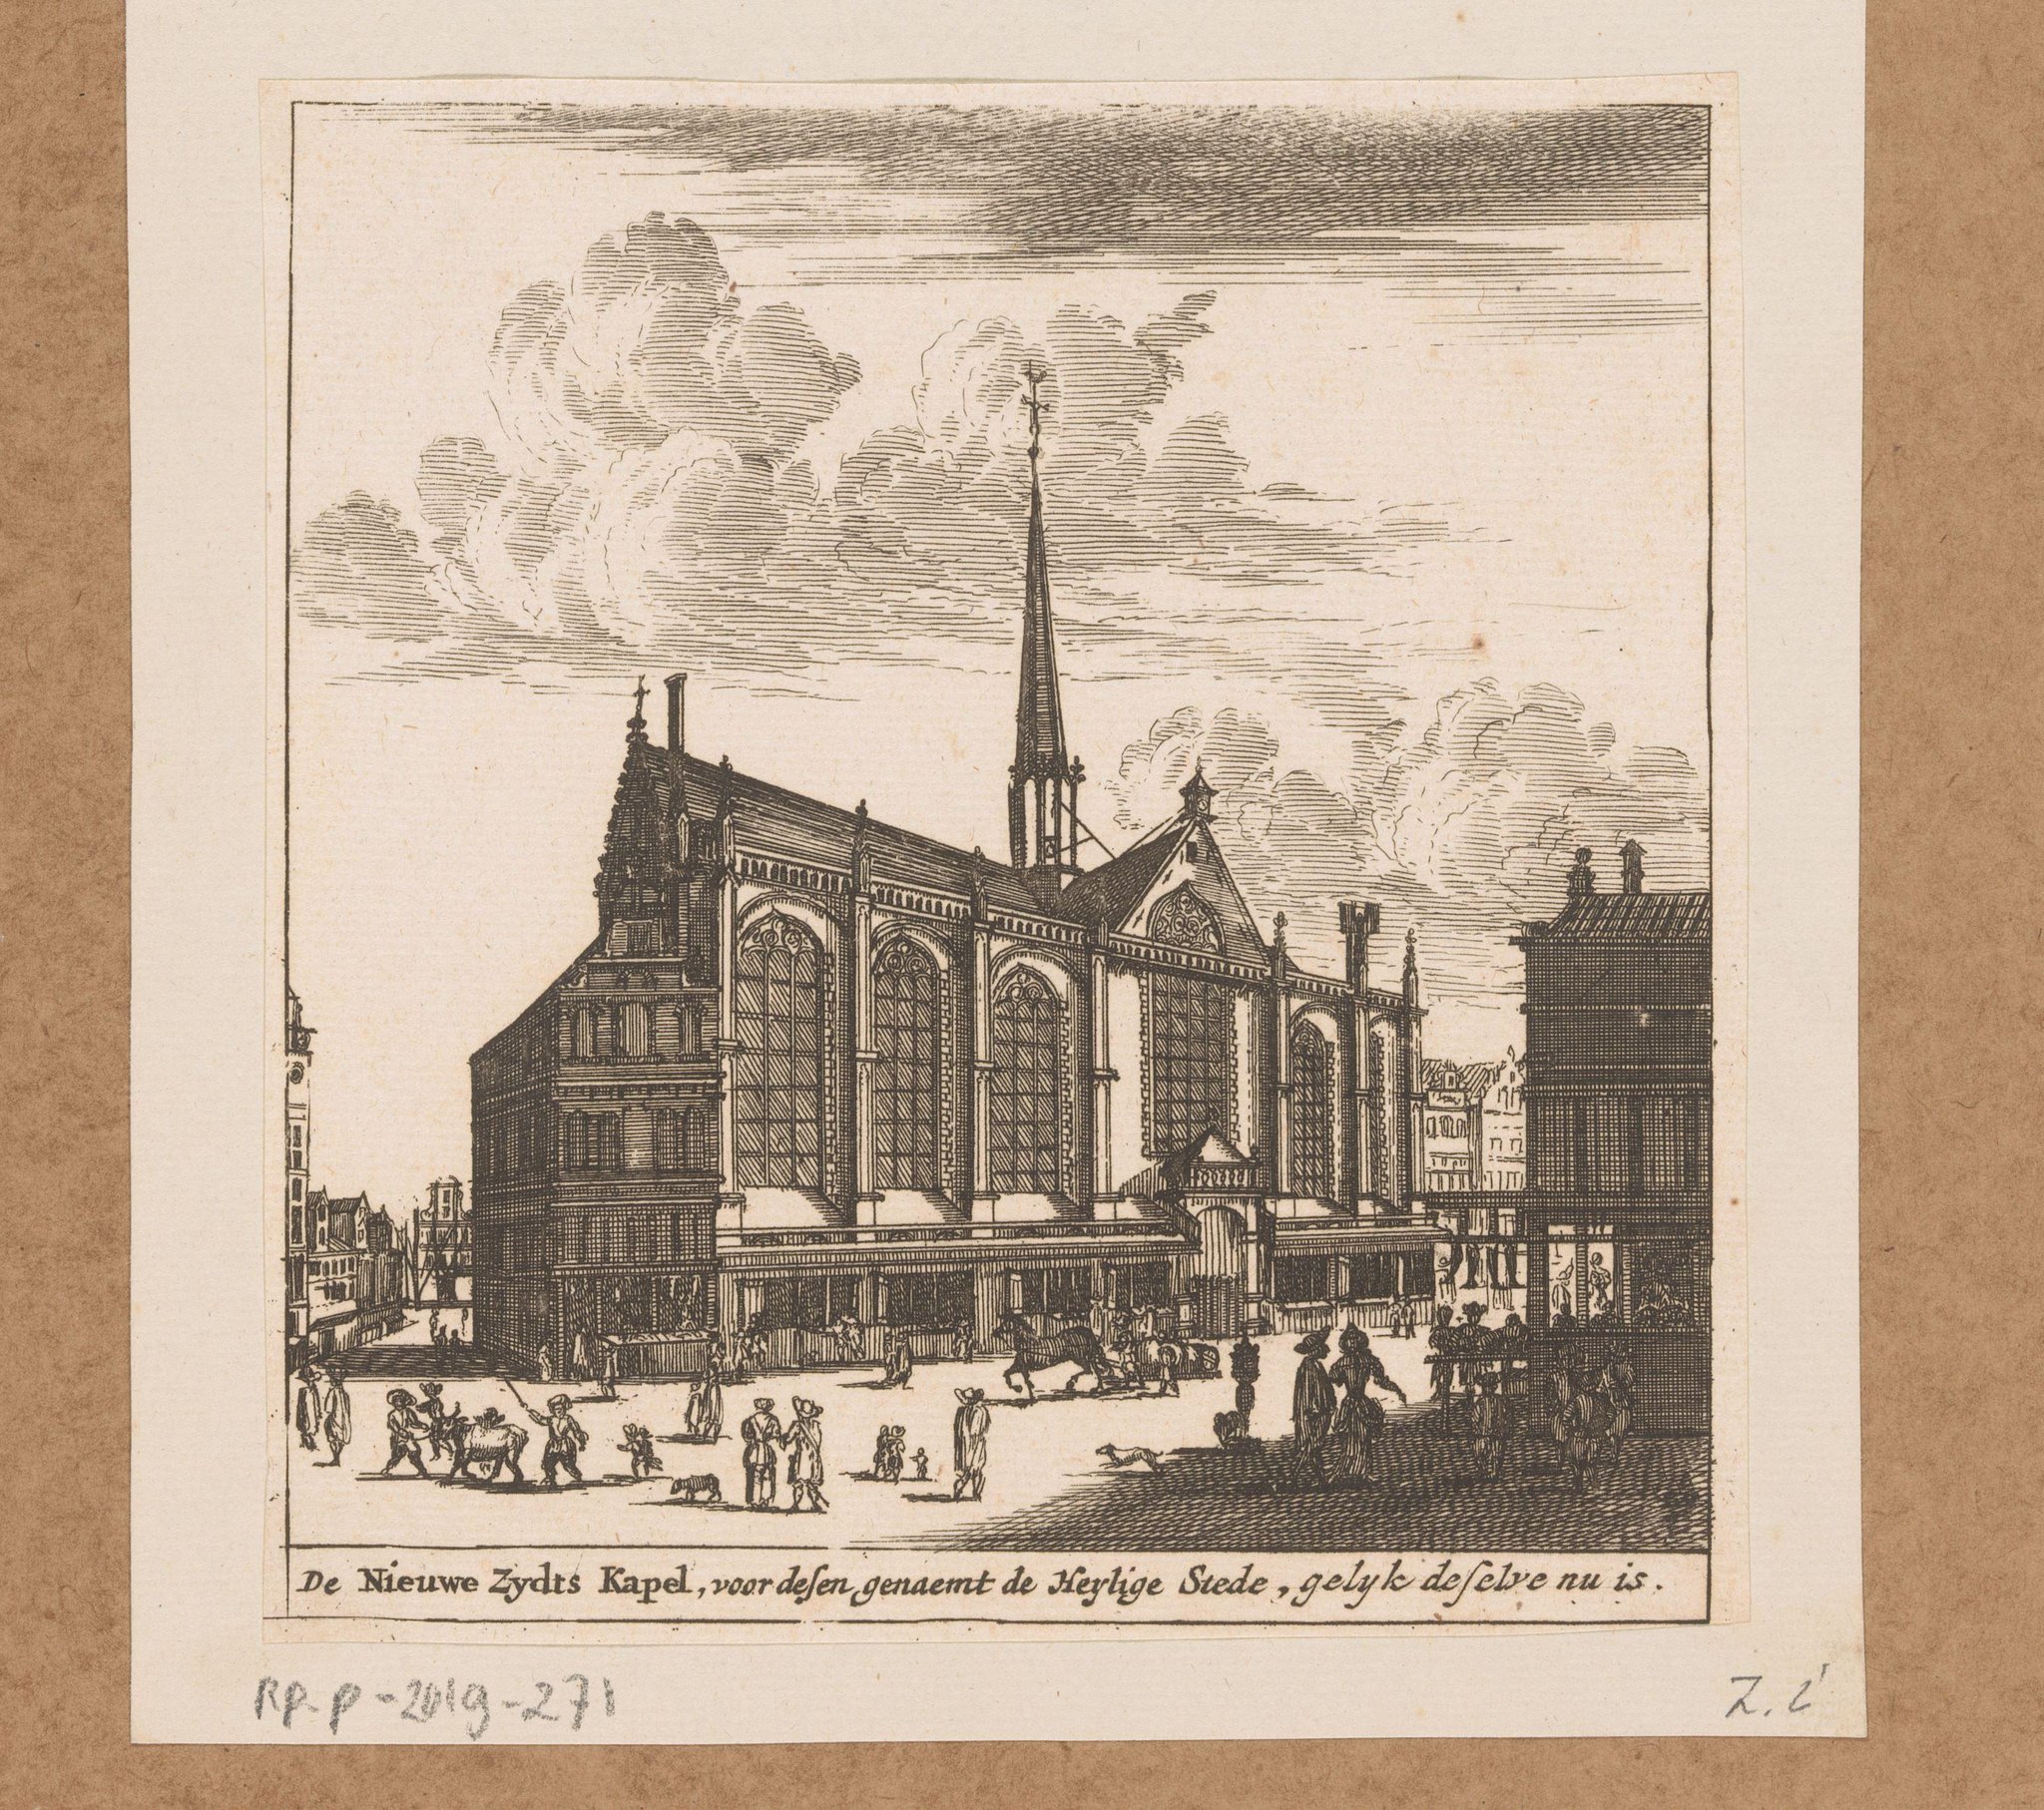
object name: print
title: De Nieuwe Zydts Kapel, voor dezen genaemt de Heylige Stede, gelijk dezelve nu is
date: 1729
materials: paper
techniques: etching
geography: amsterdam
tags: church (exterior), street (+ city(-scape) with figures, staffage)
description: Prent uit: Long, Isaac le. Historische beschryvinge van de reformatie der stadt Amsterdam (…). Amsterdam: Johannes van Septeren (I), 1729, tussen p. 566 en 567.